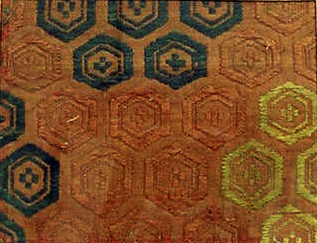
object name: piece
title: Textile with Floral Hexagons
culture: japanese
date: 1615-1868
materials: silk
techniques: brocade, weave